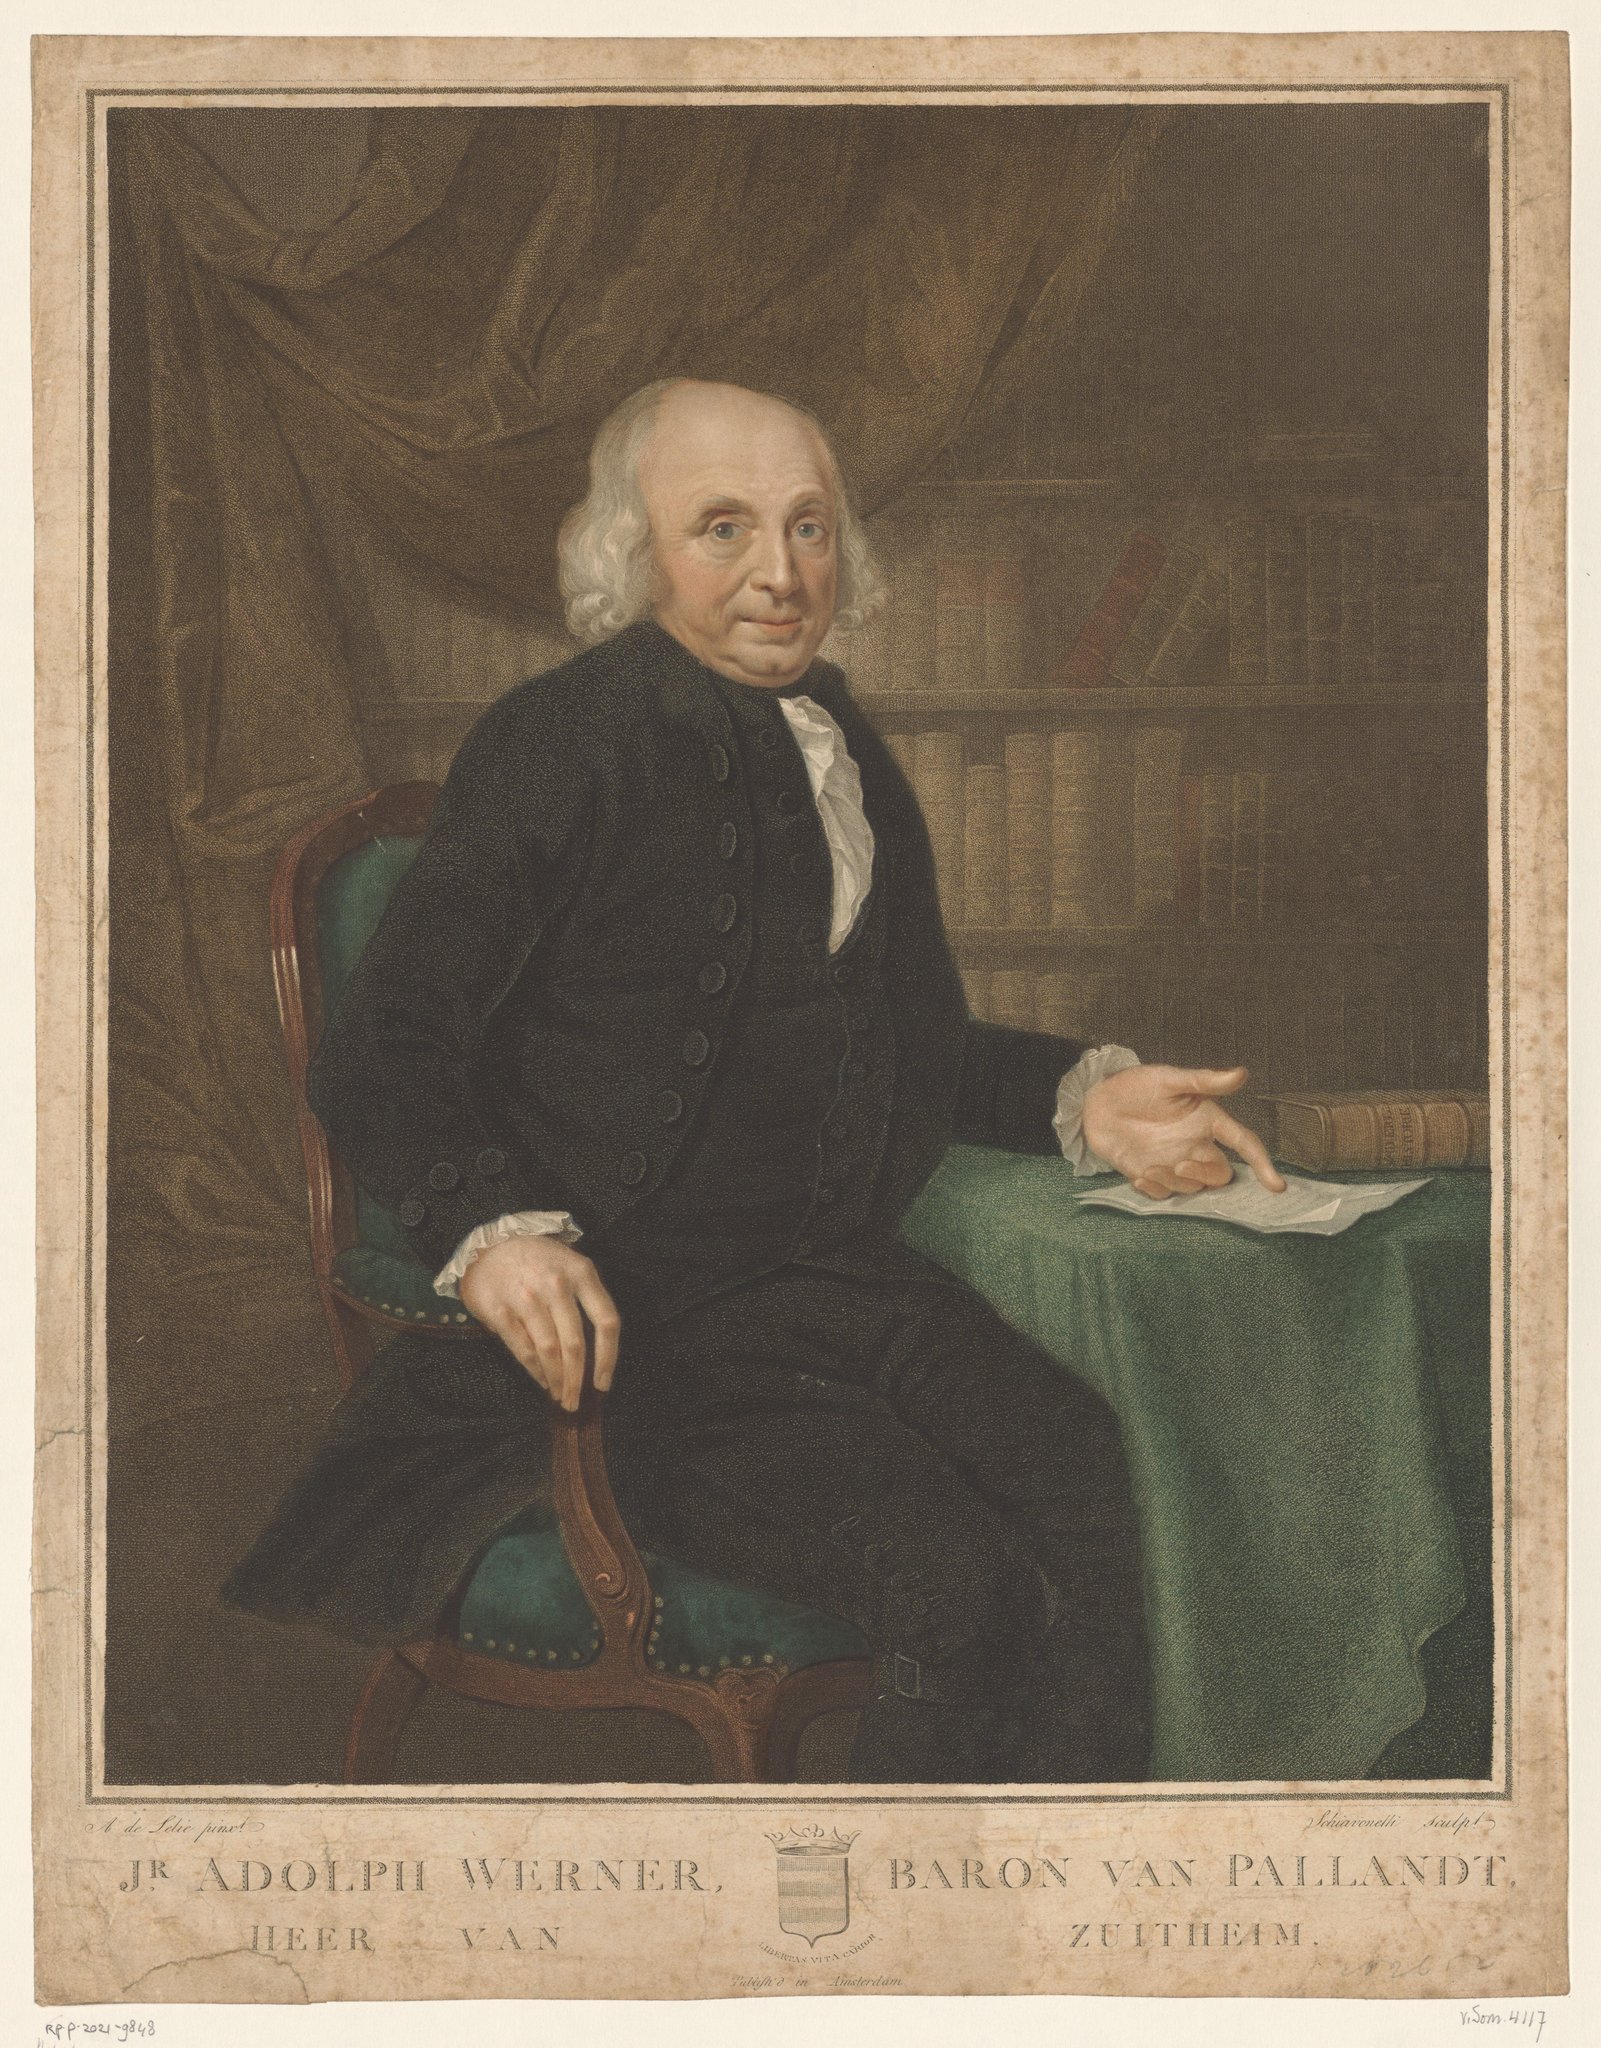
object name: print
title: Portret van Adolph Werner van Pallandt tot Zuthem, drost van IJsselmuiden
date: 1790-1810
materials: paper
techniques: engraving, etching, lithography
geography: amsterdam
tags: adult man, historical persons, book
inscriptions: collector's mark: Lugt 2228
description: Prent naar een schilderij door Adriaan de Lelie in het Stedelijk Museum Zwolle (inv.nr. 408).